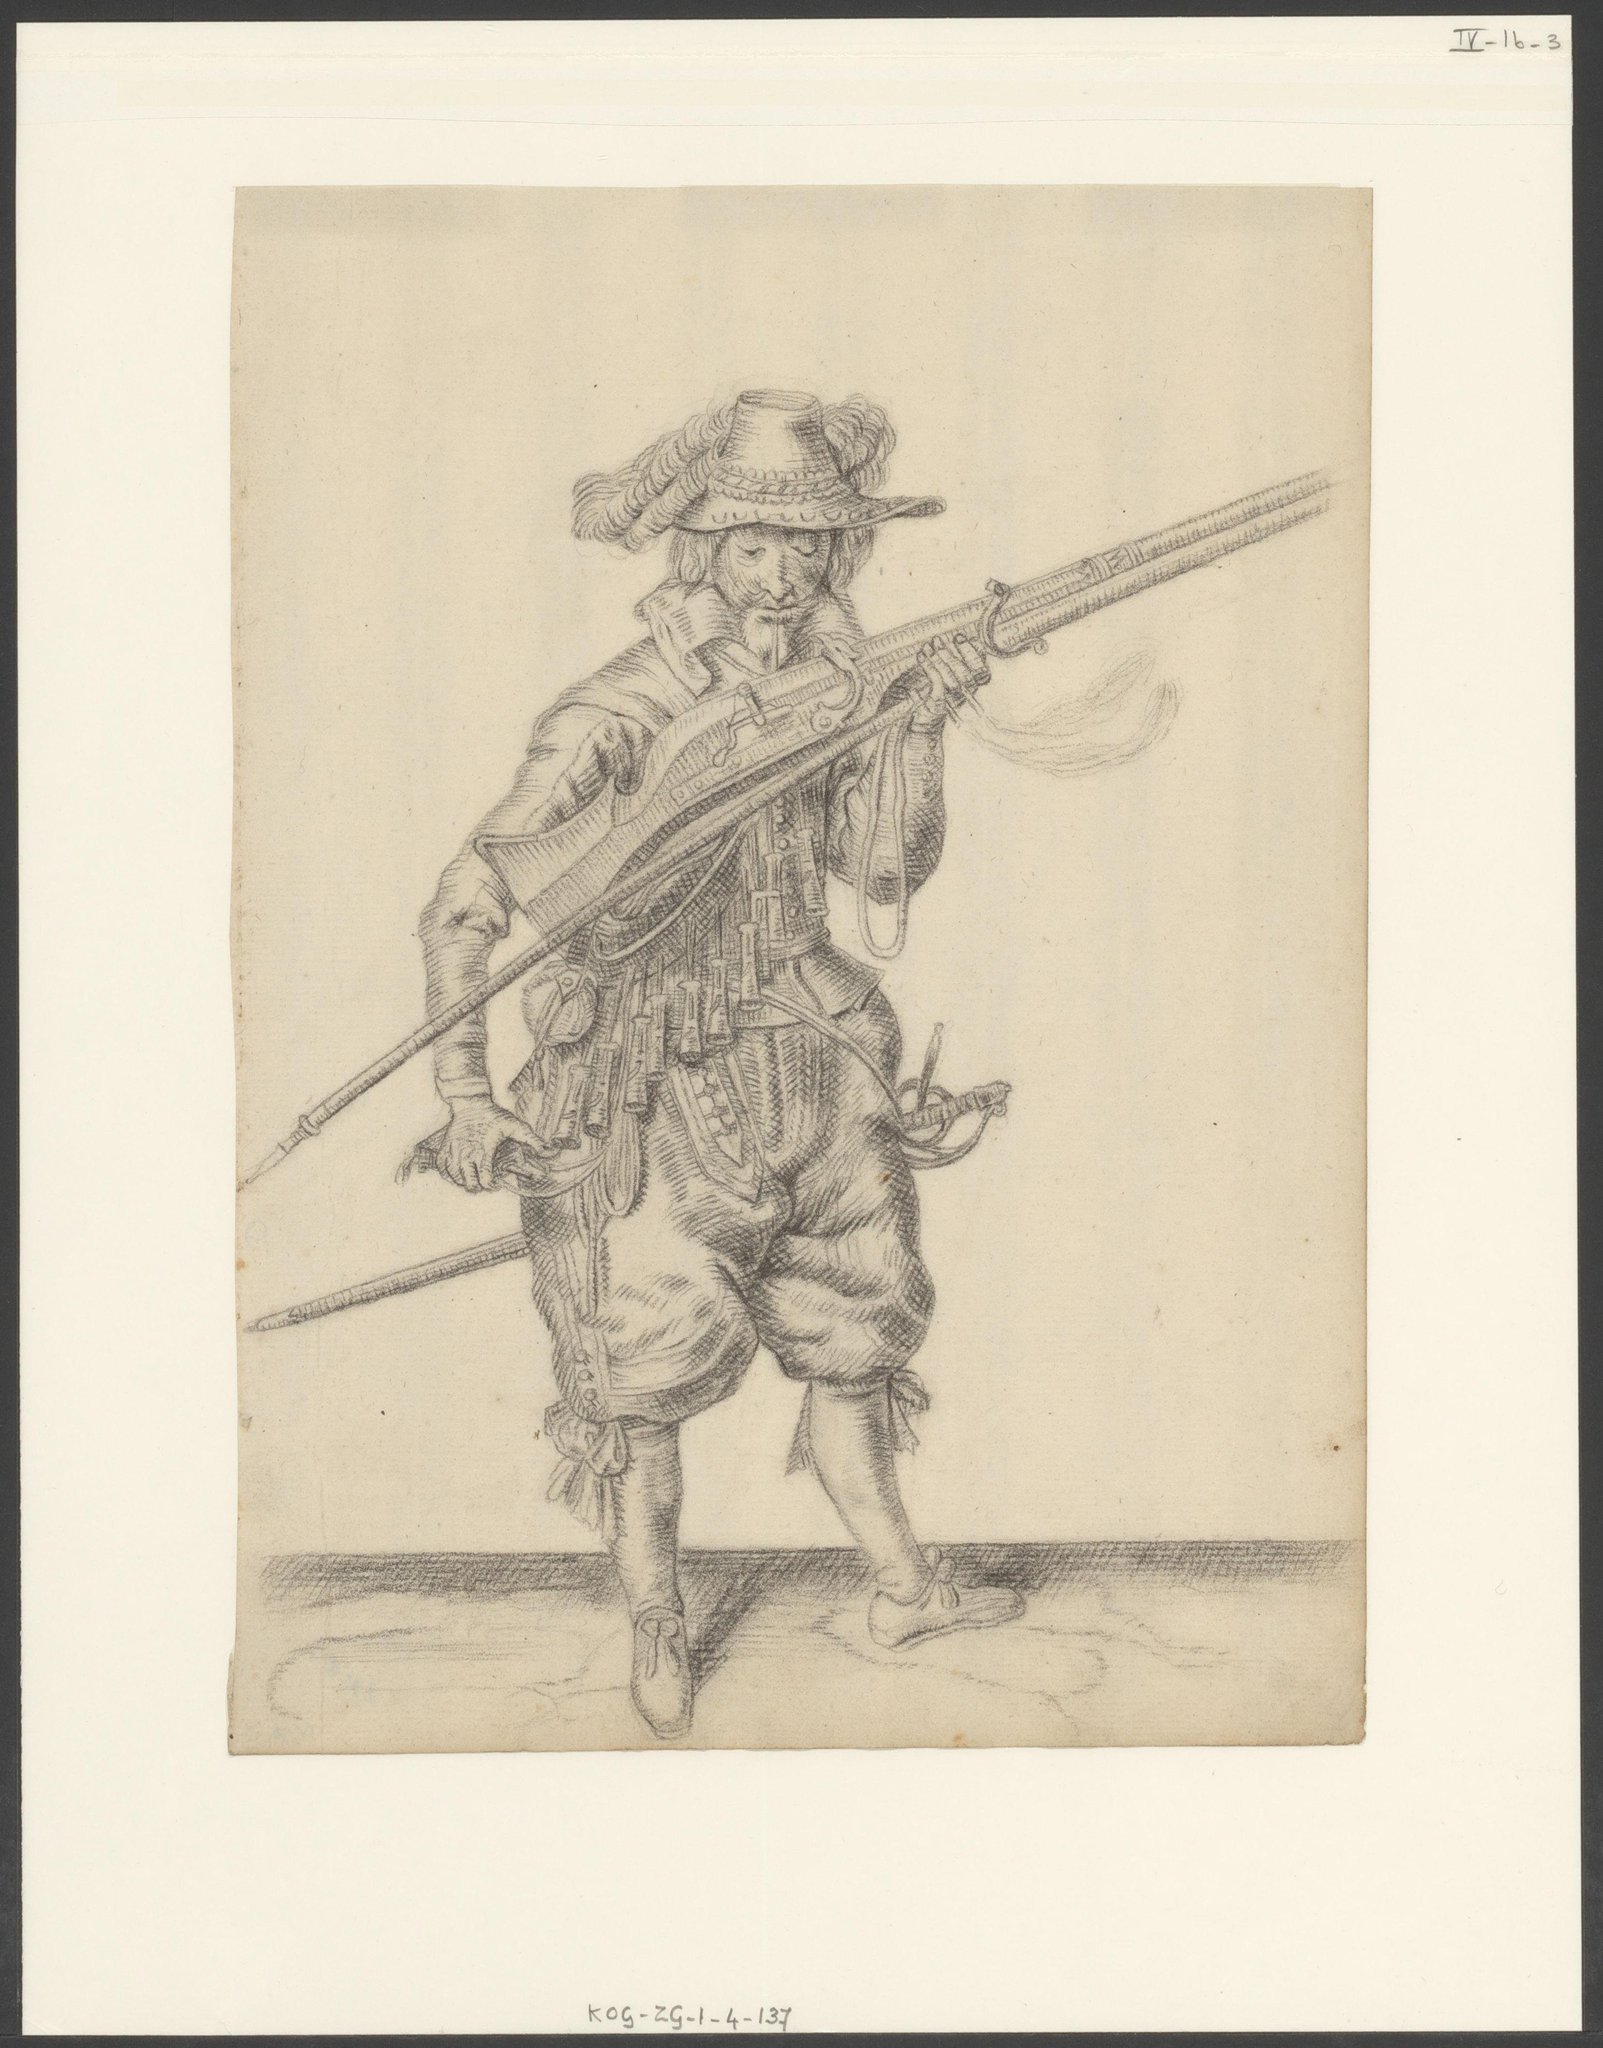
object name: drawing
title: Soldaat die vonken wegblaast van de pan van zijn musket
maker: Anonymous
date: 1750-1900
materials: chalk, paper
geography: northern netherlands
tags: manoeuvre ~ military training, handling of weapons ~ military training, firearms: rifle, (military) uniforms